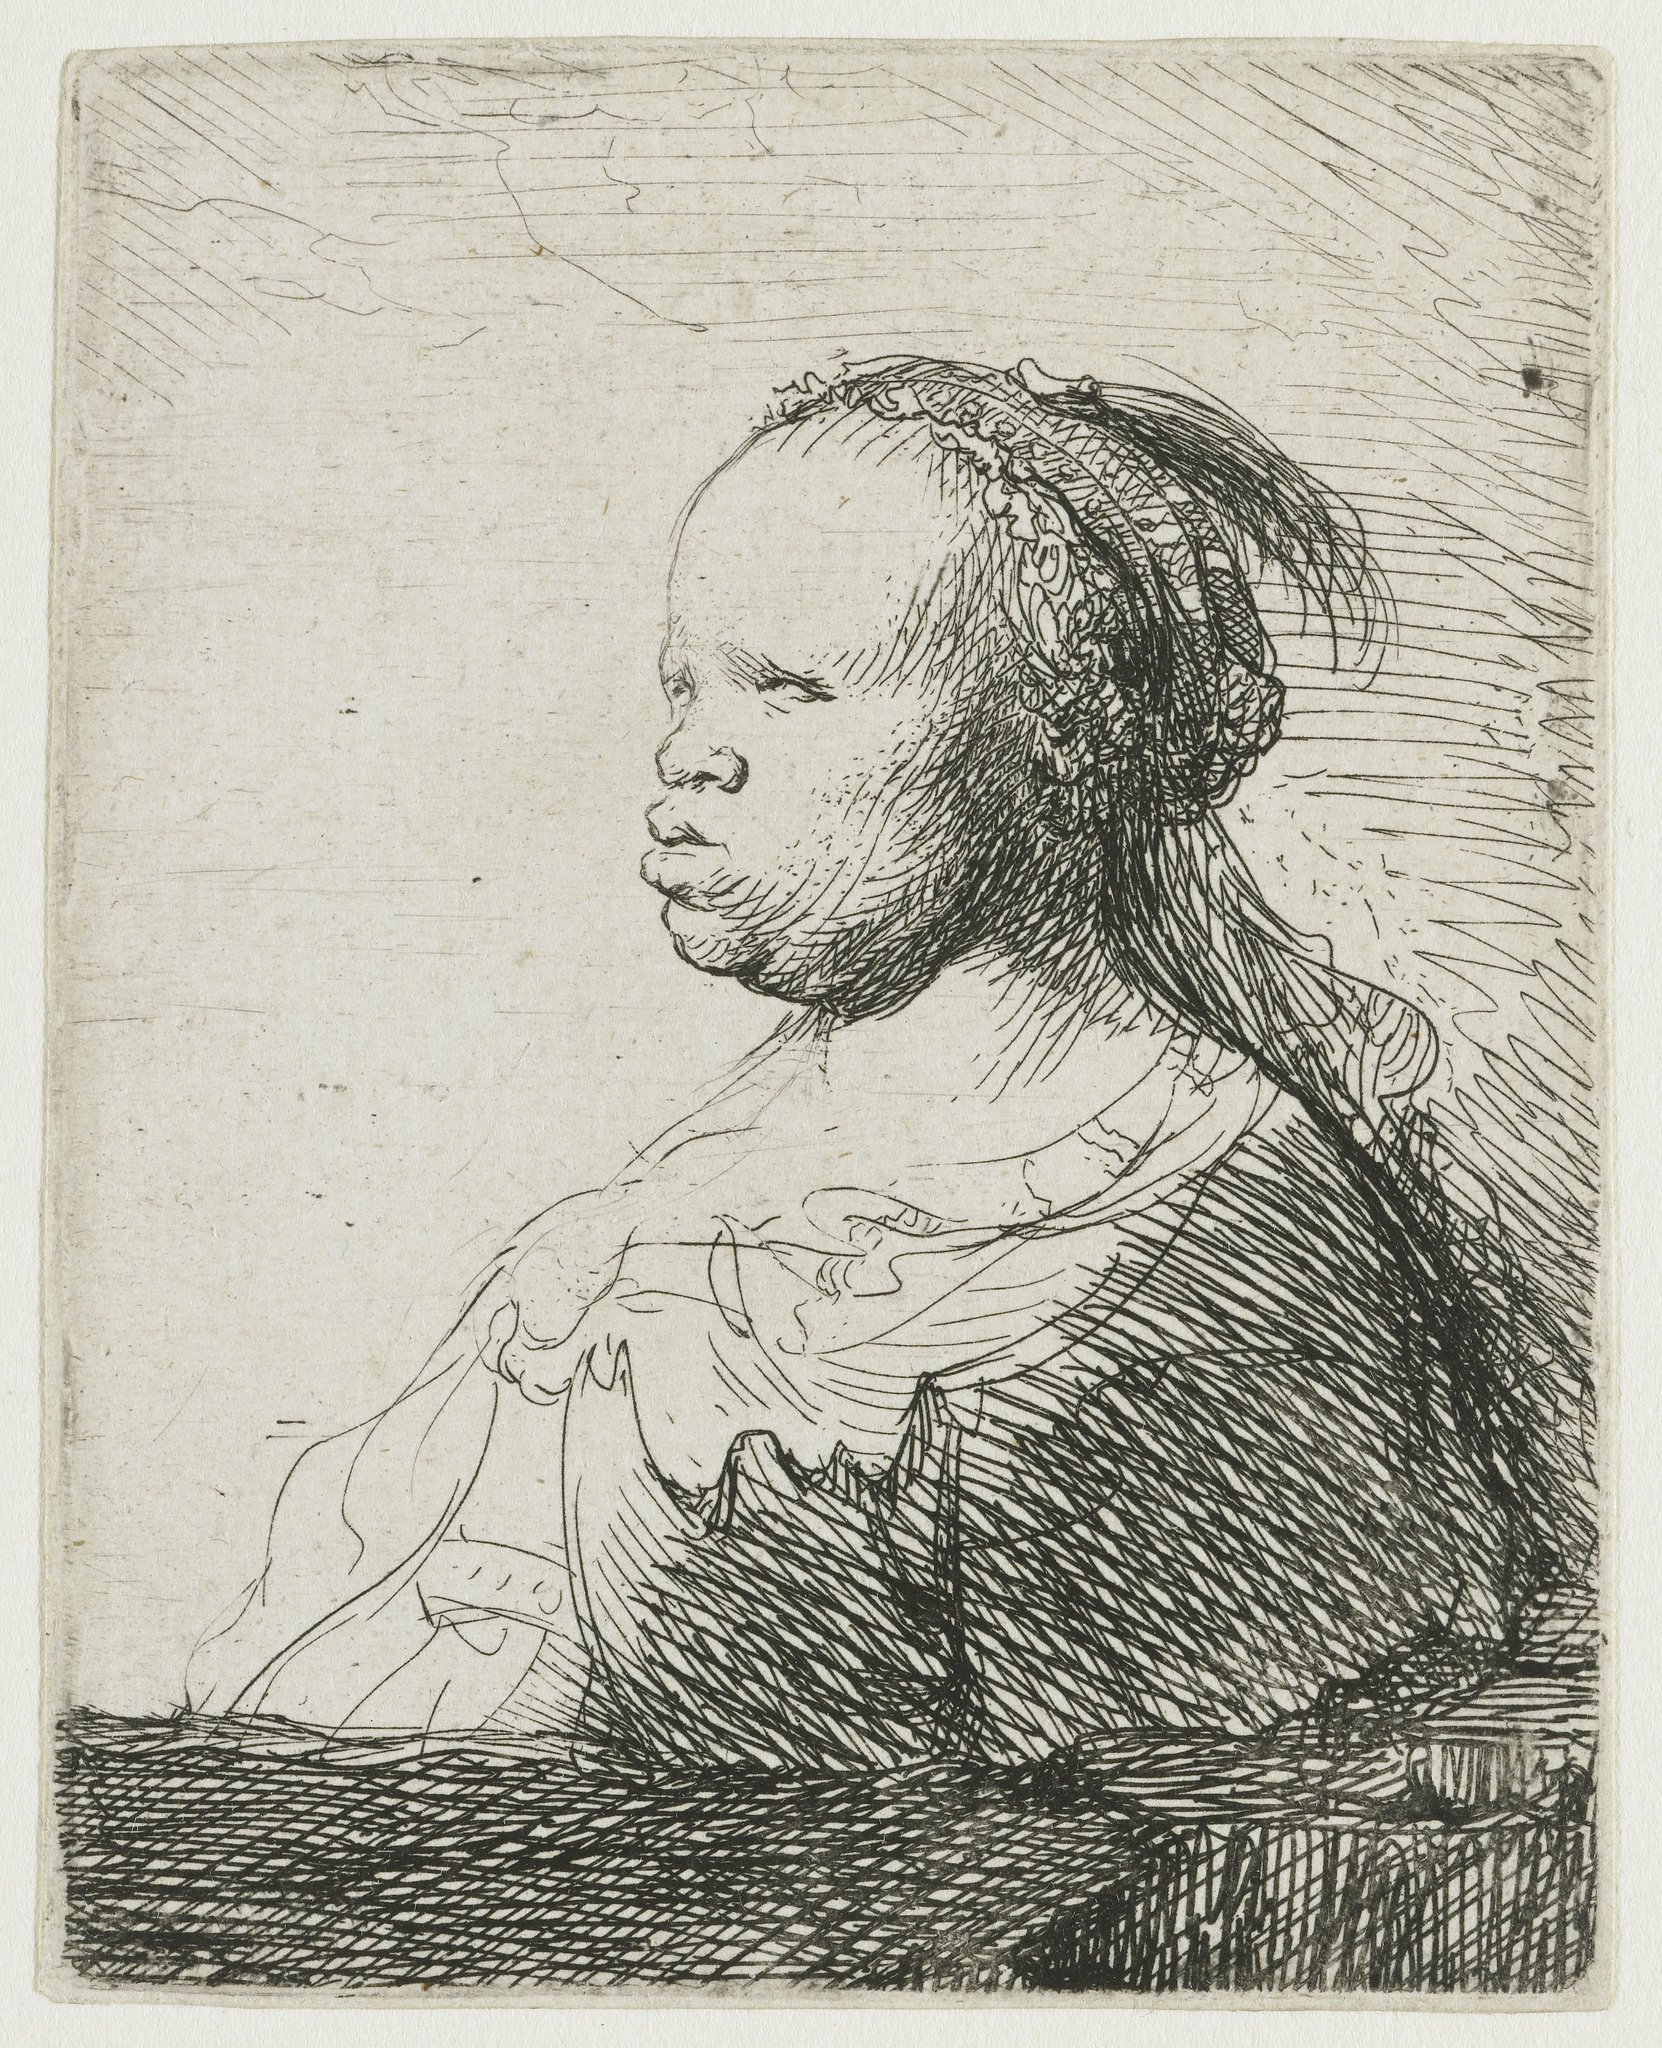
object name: print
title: The white negress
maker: rembrandt van rijn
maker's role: draughtsman, painter, print maker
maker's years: 1606-1669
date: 1630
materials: paper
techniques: etching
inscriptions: collector's mark: Lugt 240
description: Deze prent werd reeds in 1751 (Gersaint) aangeduid als ‘La Mauresse blanche’, en in 1755 (De Burgy) als ‘Het Moorinnetje’. Vrijwel zeker gaat dit terug op een oudere traditie, die lang stand hield. Nog in 1810 (Josi) heette ze ‘Het witte Moorinnetje’. Stellig is de vrouw niet wit, maar lijkt dat zo omdat haar gezicht niet is gearceerd. De paradoxale titel heeft wel tot verwarring geleid. In 1796 duidde Daulby de prent aan als ‘a morisco’, waar hij aan toevoegde: “the face of this woman is the character of a Moor, but her complexion is fair”.